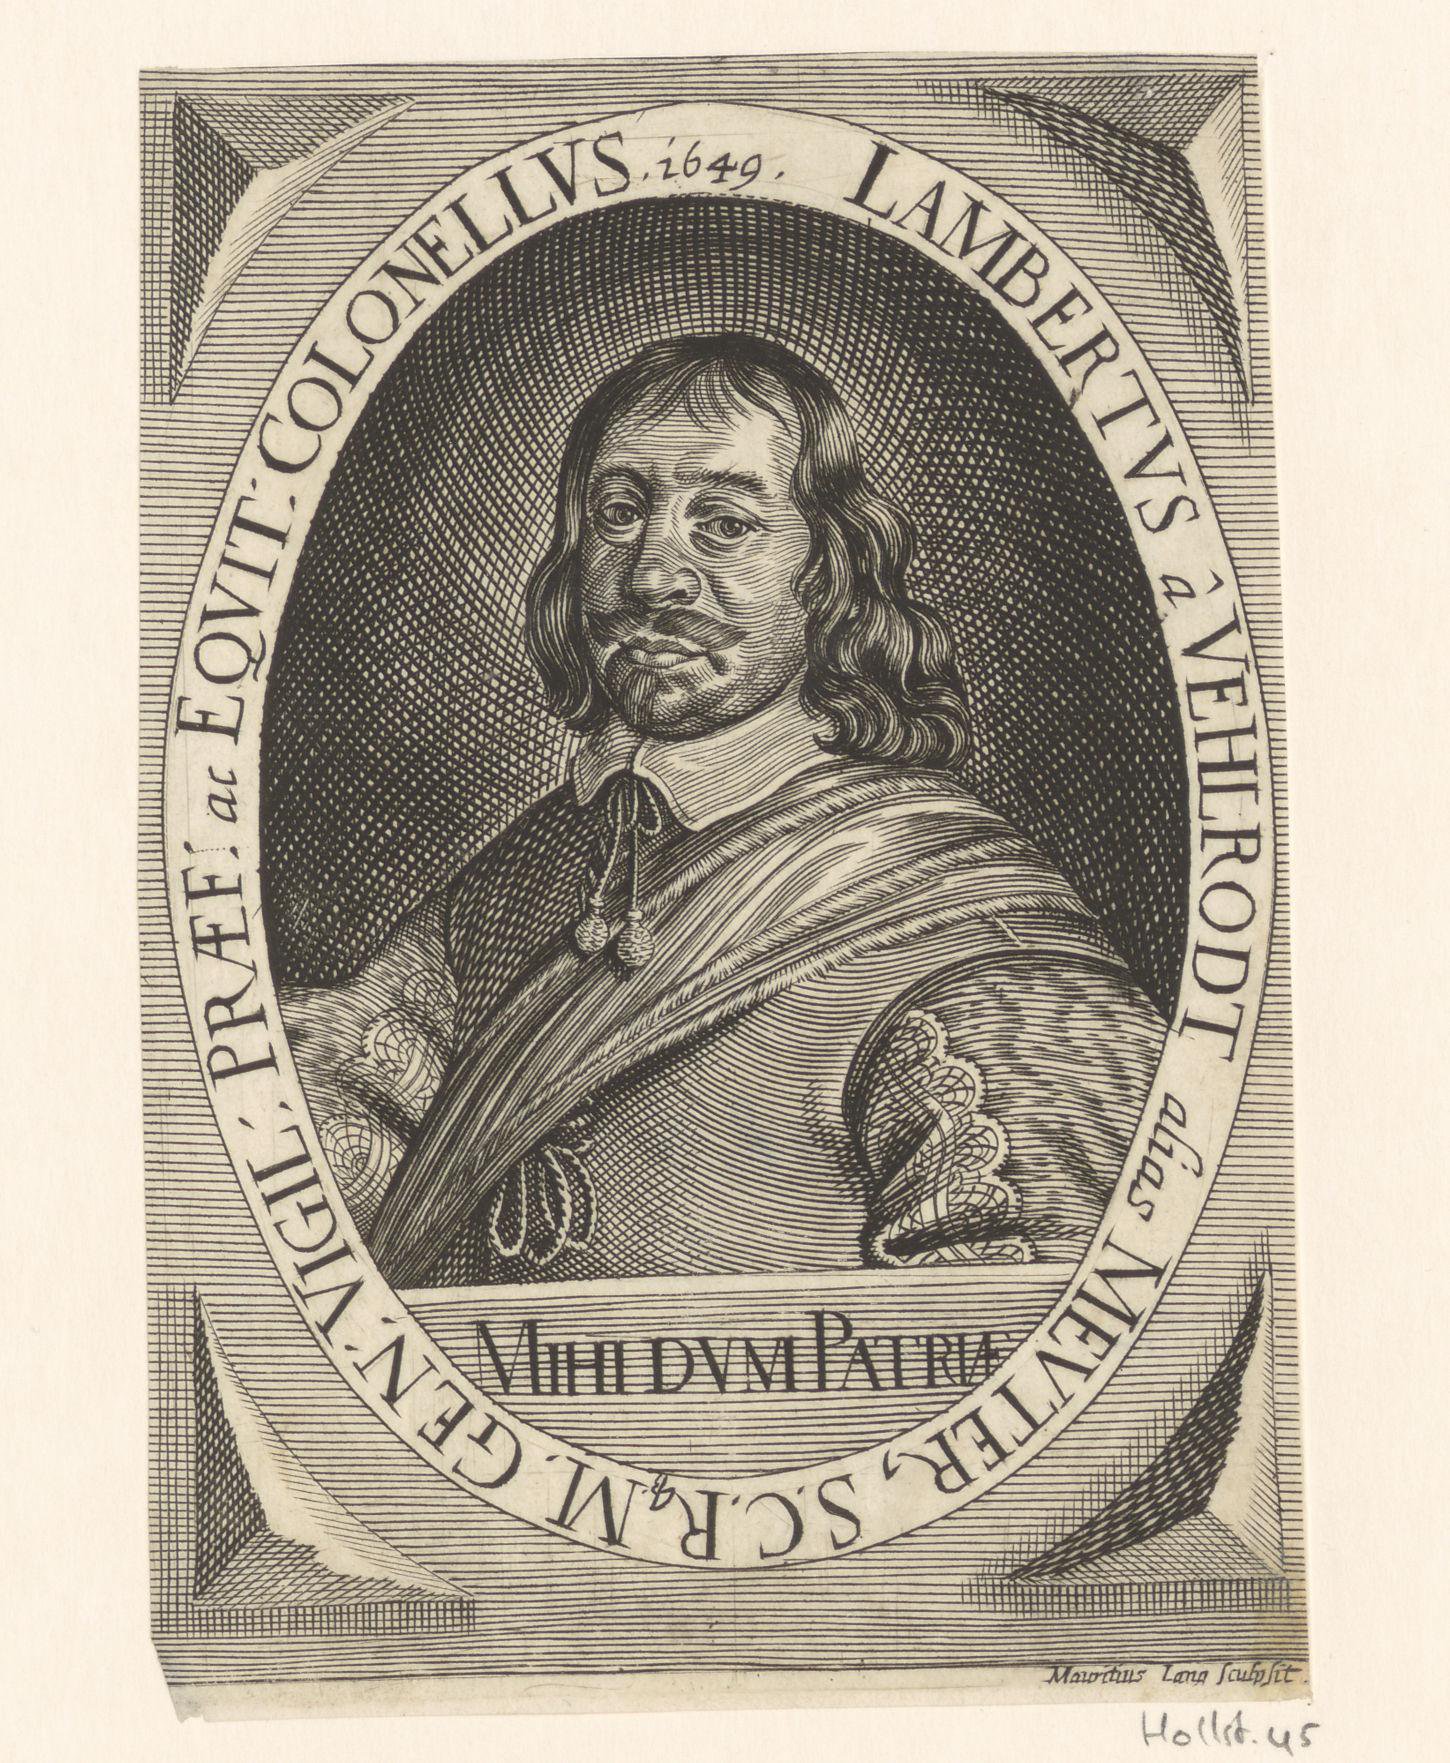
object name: print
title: Portret van Lambert von Velrath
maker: moritz lang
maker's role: draughtsman, print maker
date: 1649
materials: paper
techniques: engraving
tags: historical persons, officer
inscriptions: collector's mark: Lugt 2228